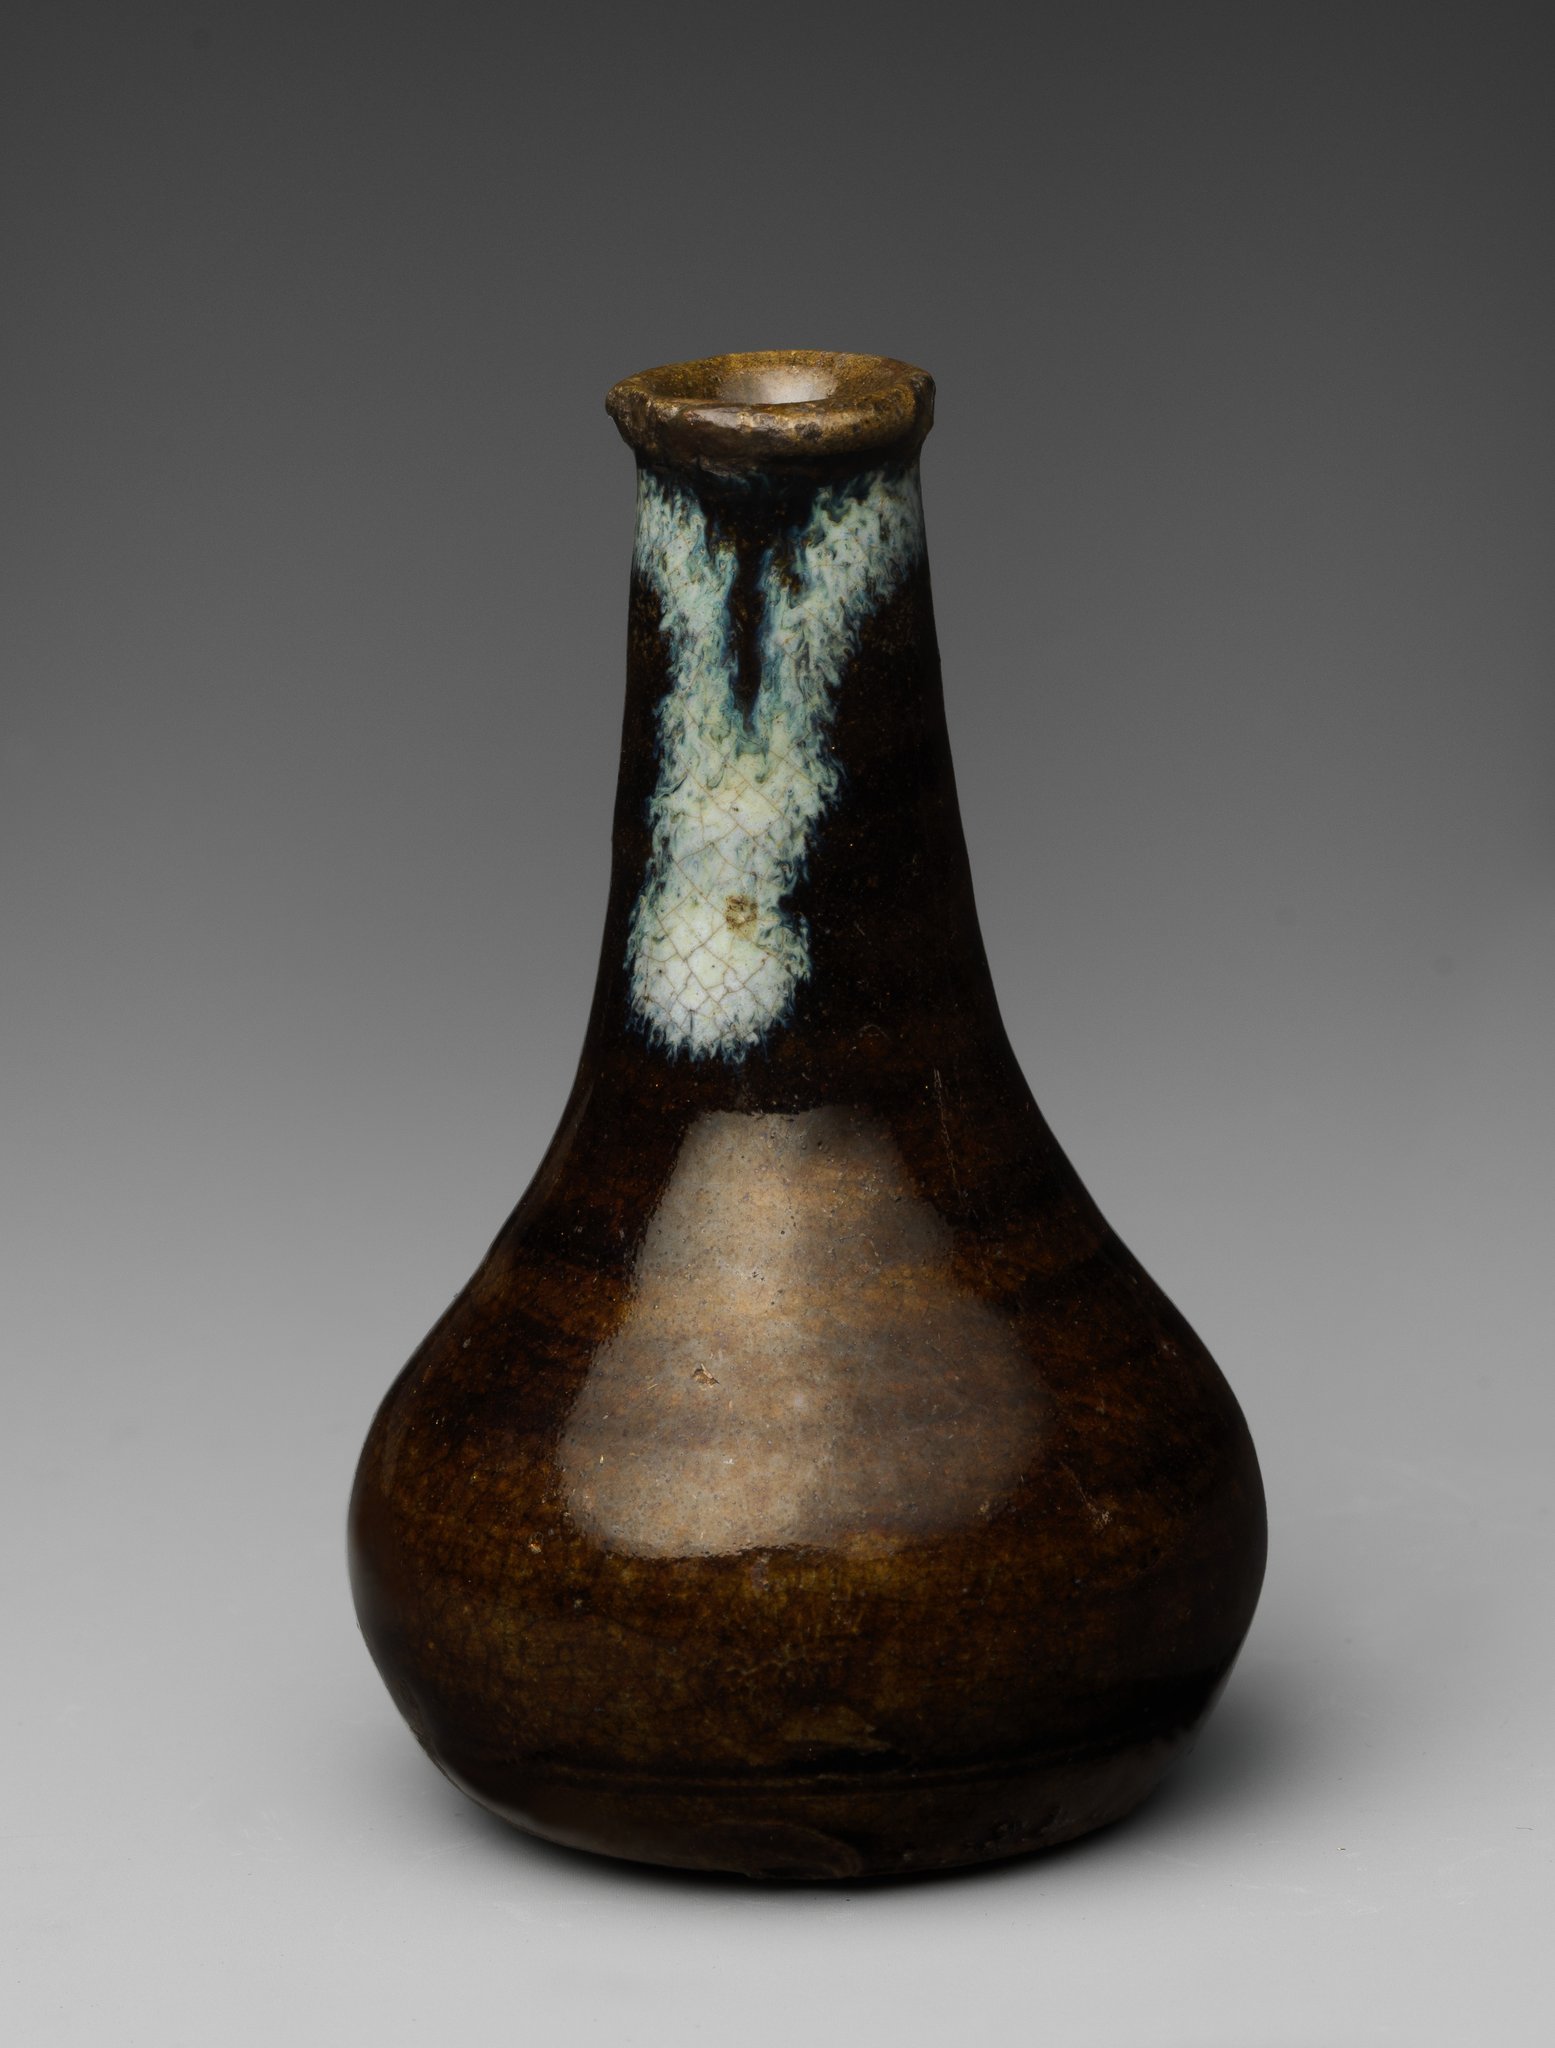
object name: vase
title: Miniature Vase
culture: japanese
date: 1700-1750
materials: glaze, pottery